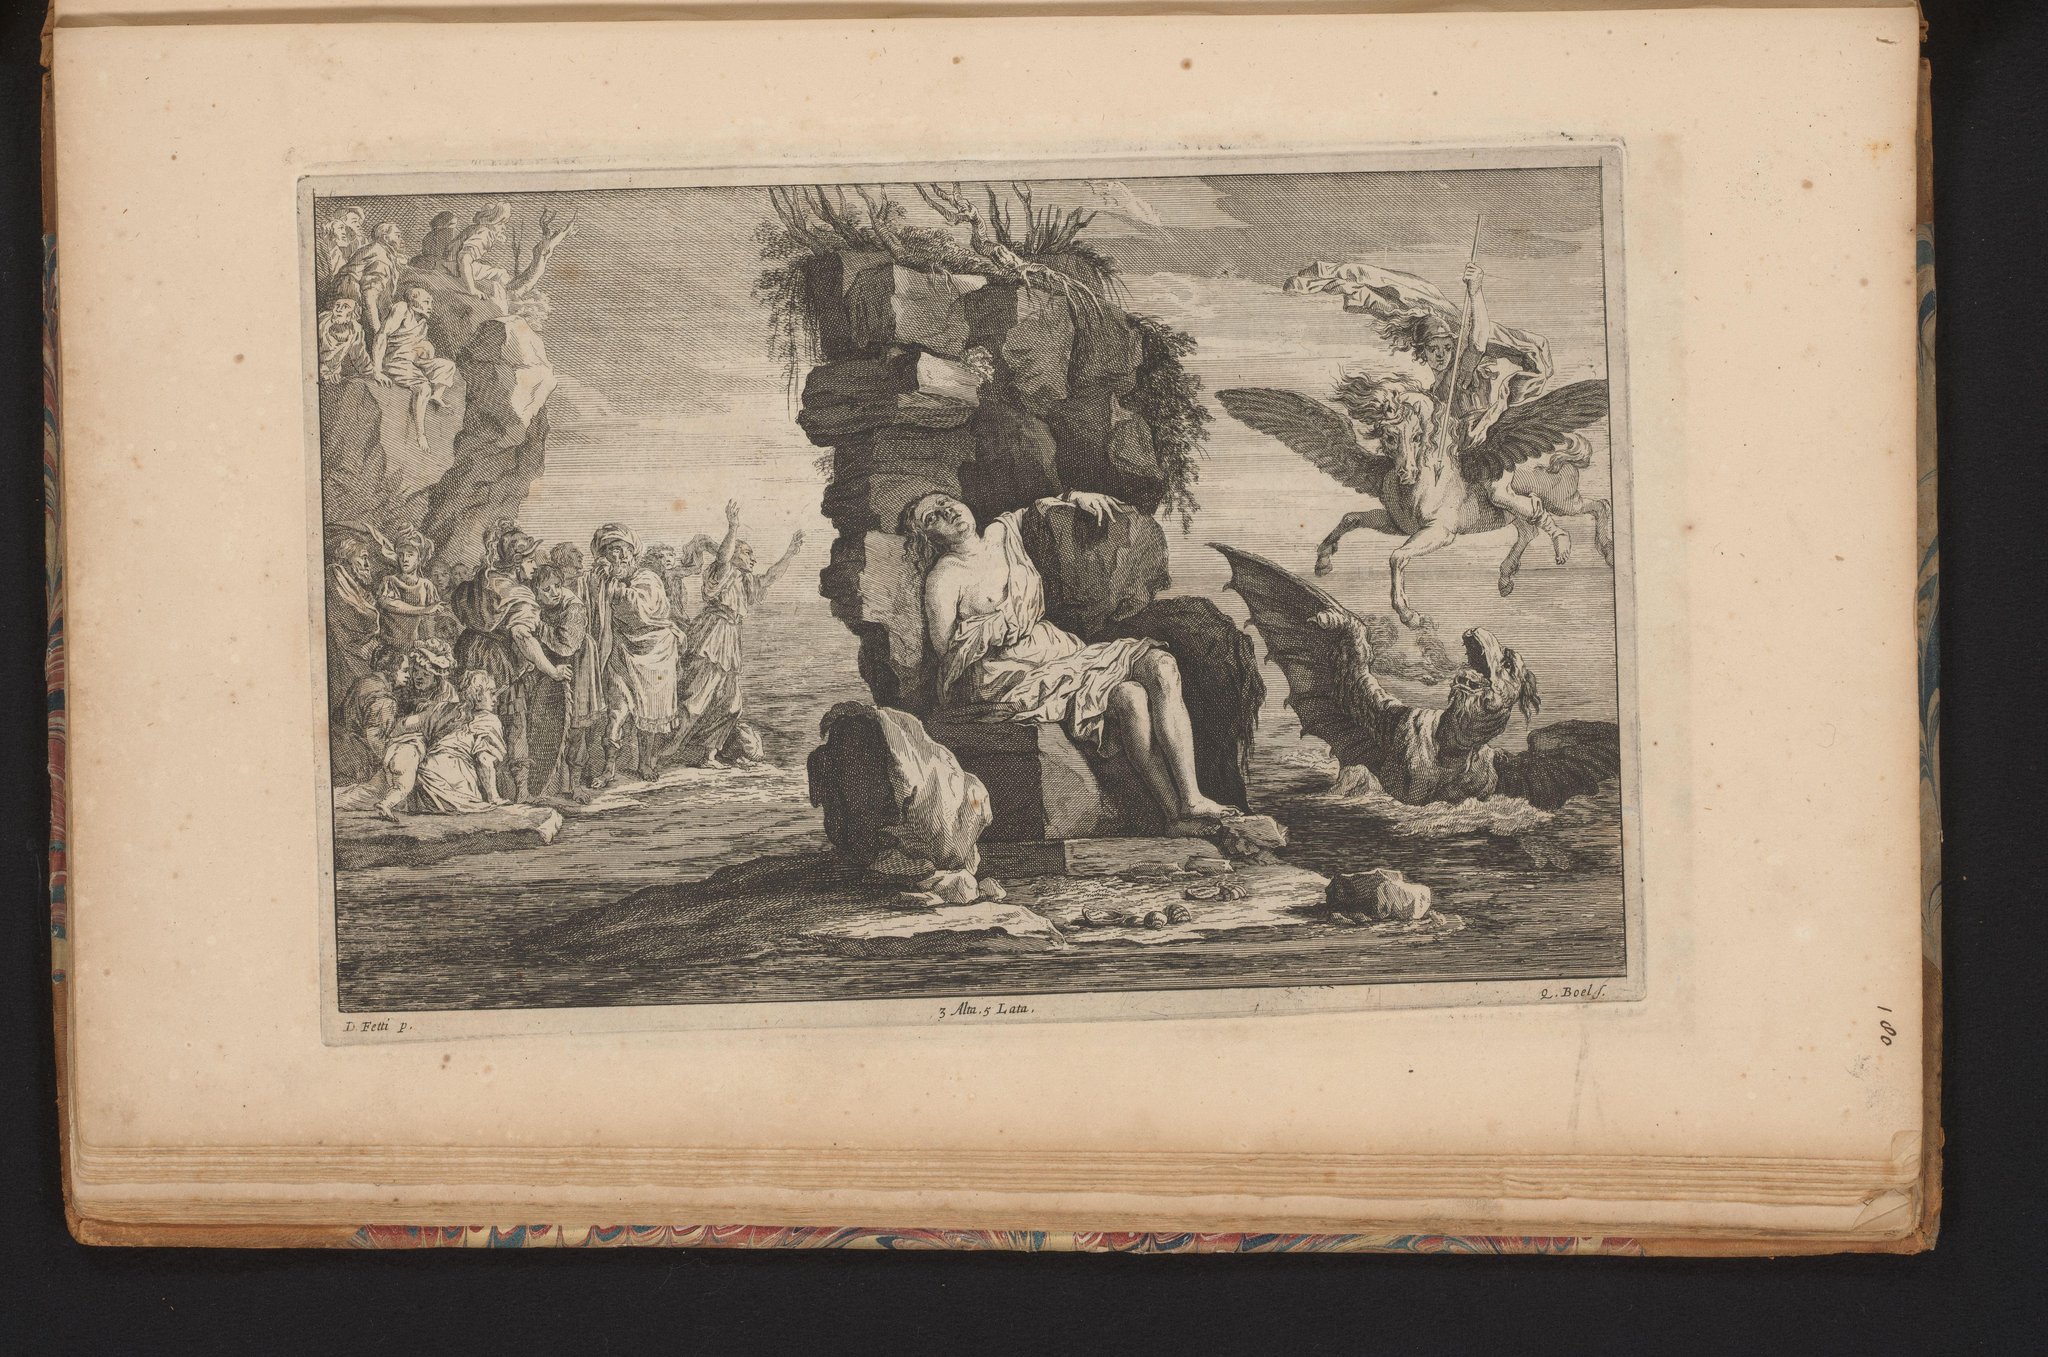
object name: album leaf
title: Perseus en Andromeda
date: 1660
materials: paper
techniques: etching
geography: italy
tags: perseus kills the sea monster (or turns it into stone by showing it the gorgon's head) to release andromeda; sometimes her parents cepheus and cassiopea watch the scene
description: De prent is vervaardigd naar het schilderij van Fetti dat zich in de collectie van het Kunsthistorisches Museum te Wenen bevindt (inventarisnummer GG_7722). David Teniers heeft waarschijnlijk van alle schilderijen uit de collectie van Leopold Willem van Oostenrijk een olieverfstudie op doek of paneel vervaardigd (zgn. pasticcio), die als voorbeeld voor de prentmakers diende. Het is niet altijd duidelijk of de pasticci door hem zijn gemaakt of door zijn atelier. Niet alle pasticci zijn overgeleverd.